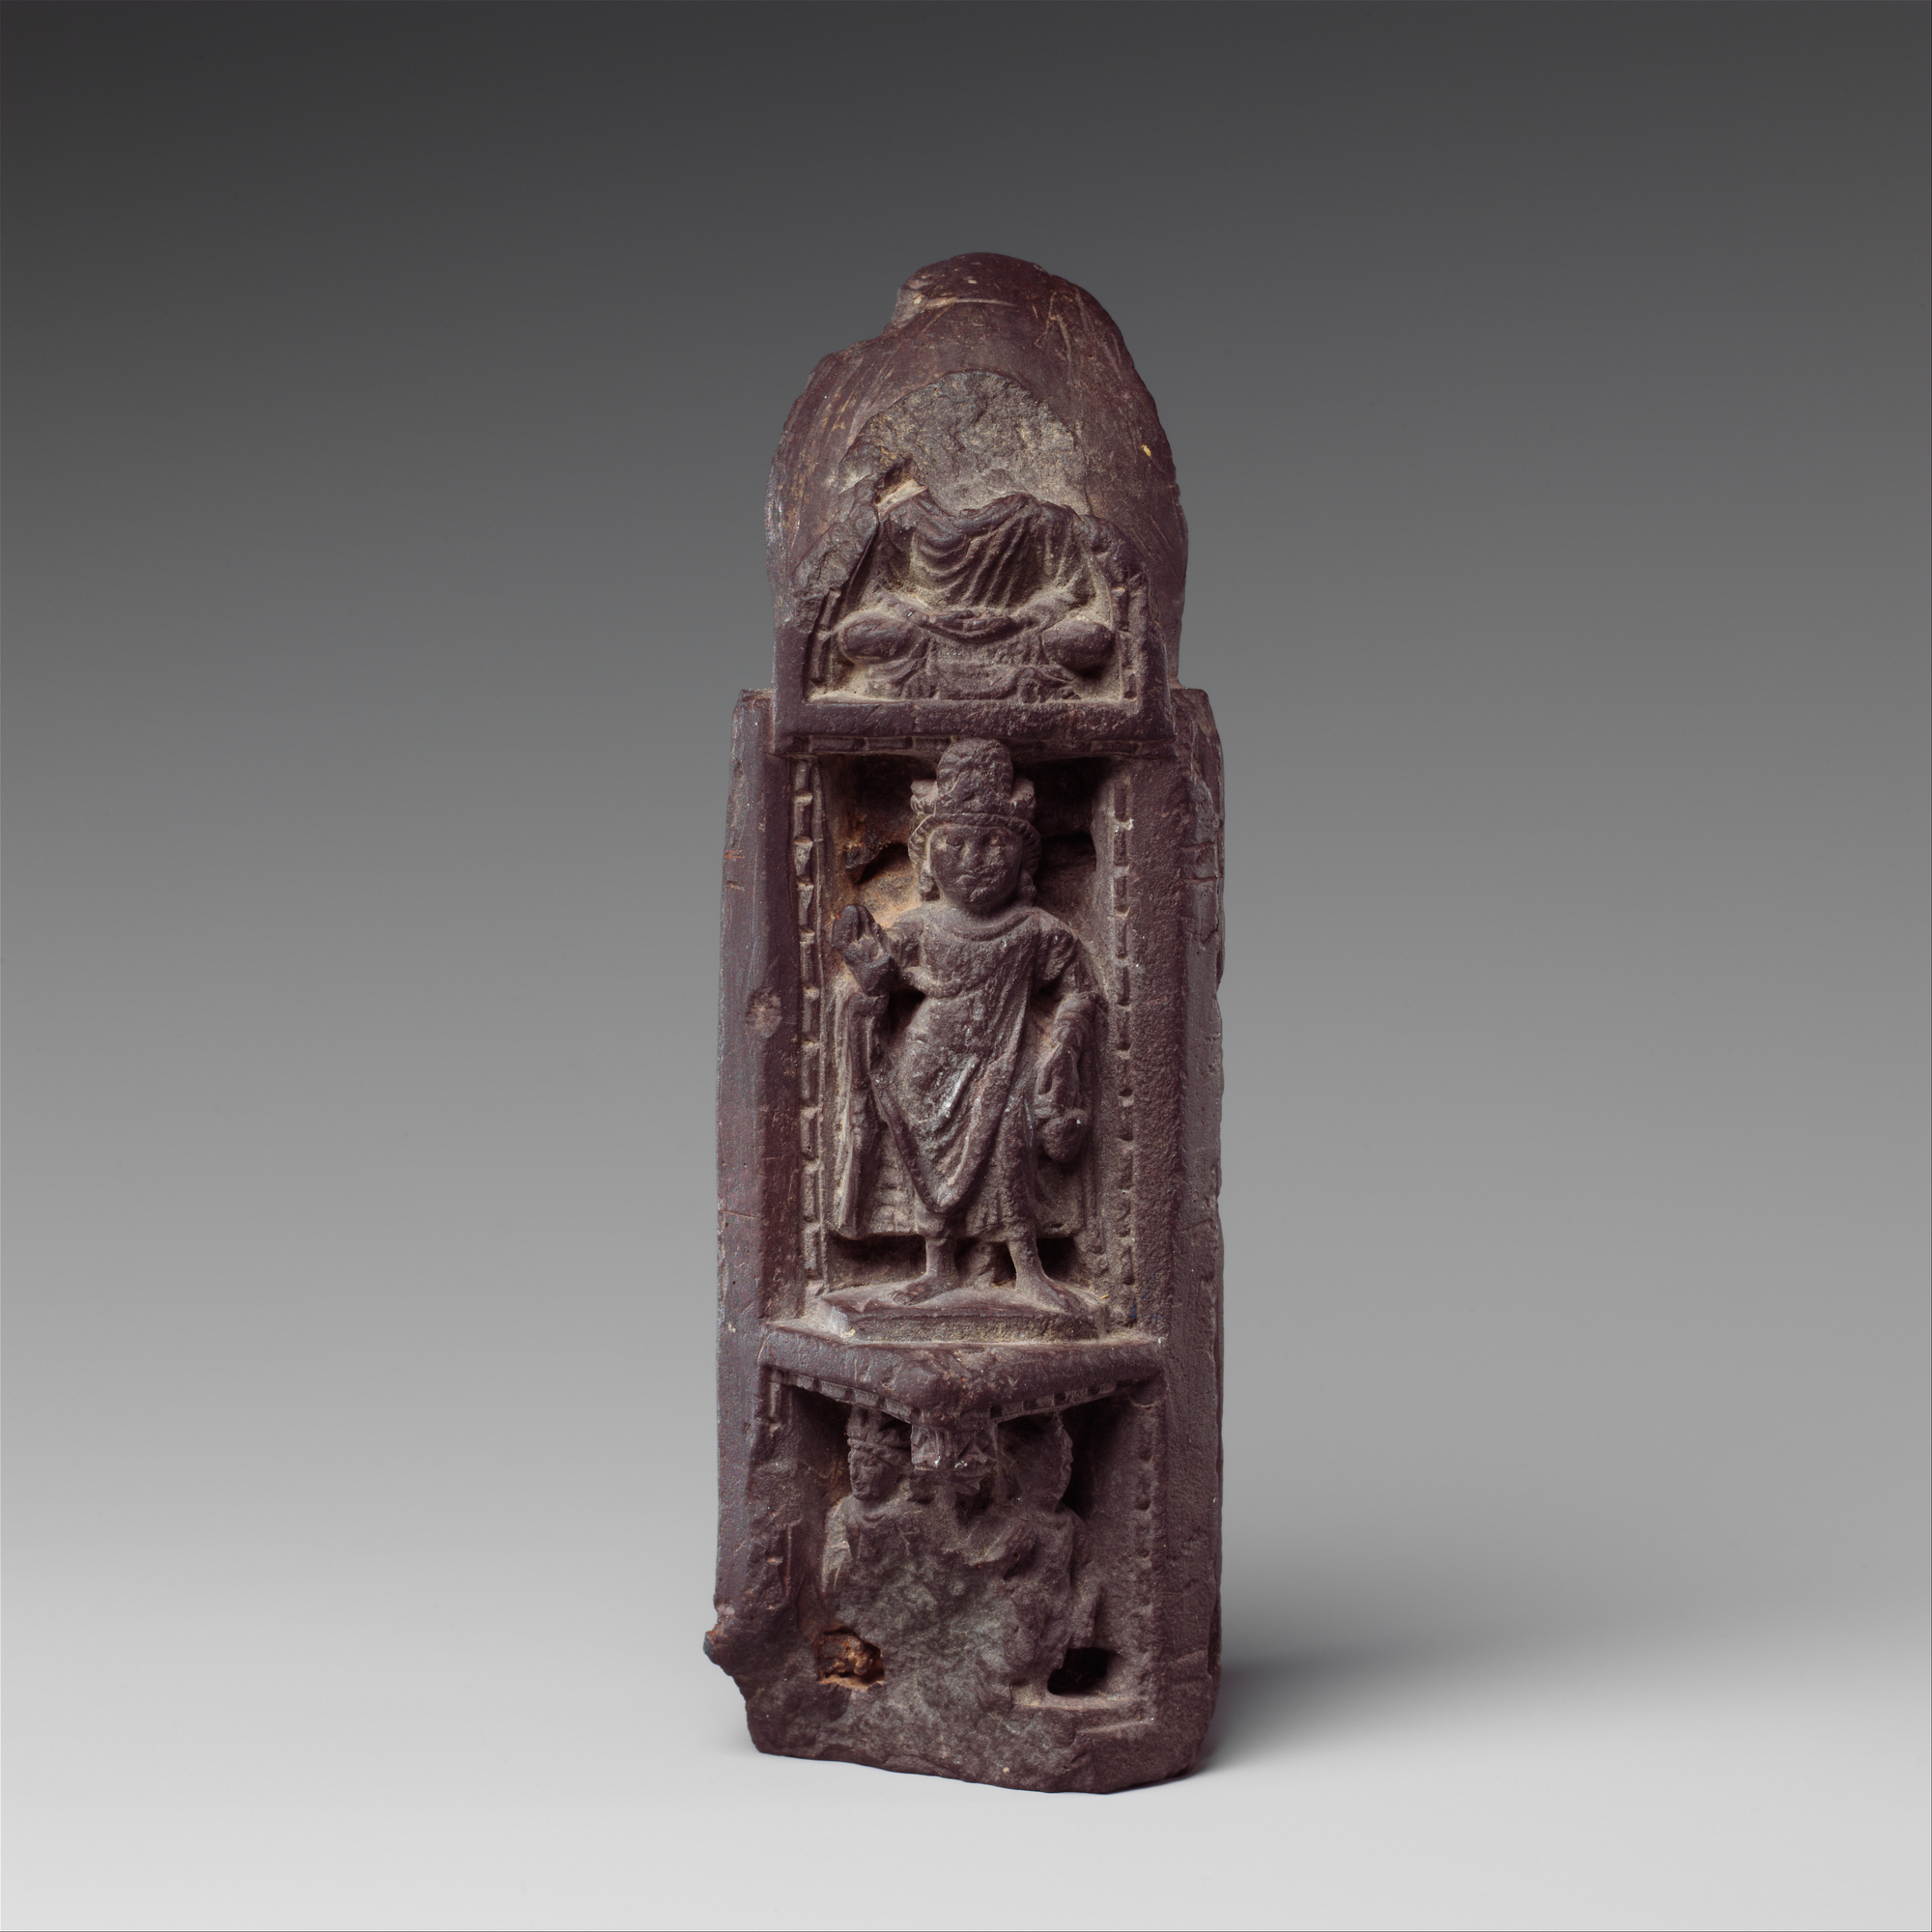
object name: portable shrine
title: Three-Sided Section of a Portable Shrine with Scenes from the Life of the Buddha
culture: gandhara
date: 401-600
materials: stone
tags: gandhara,buddha,shakyamuni